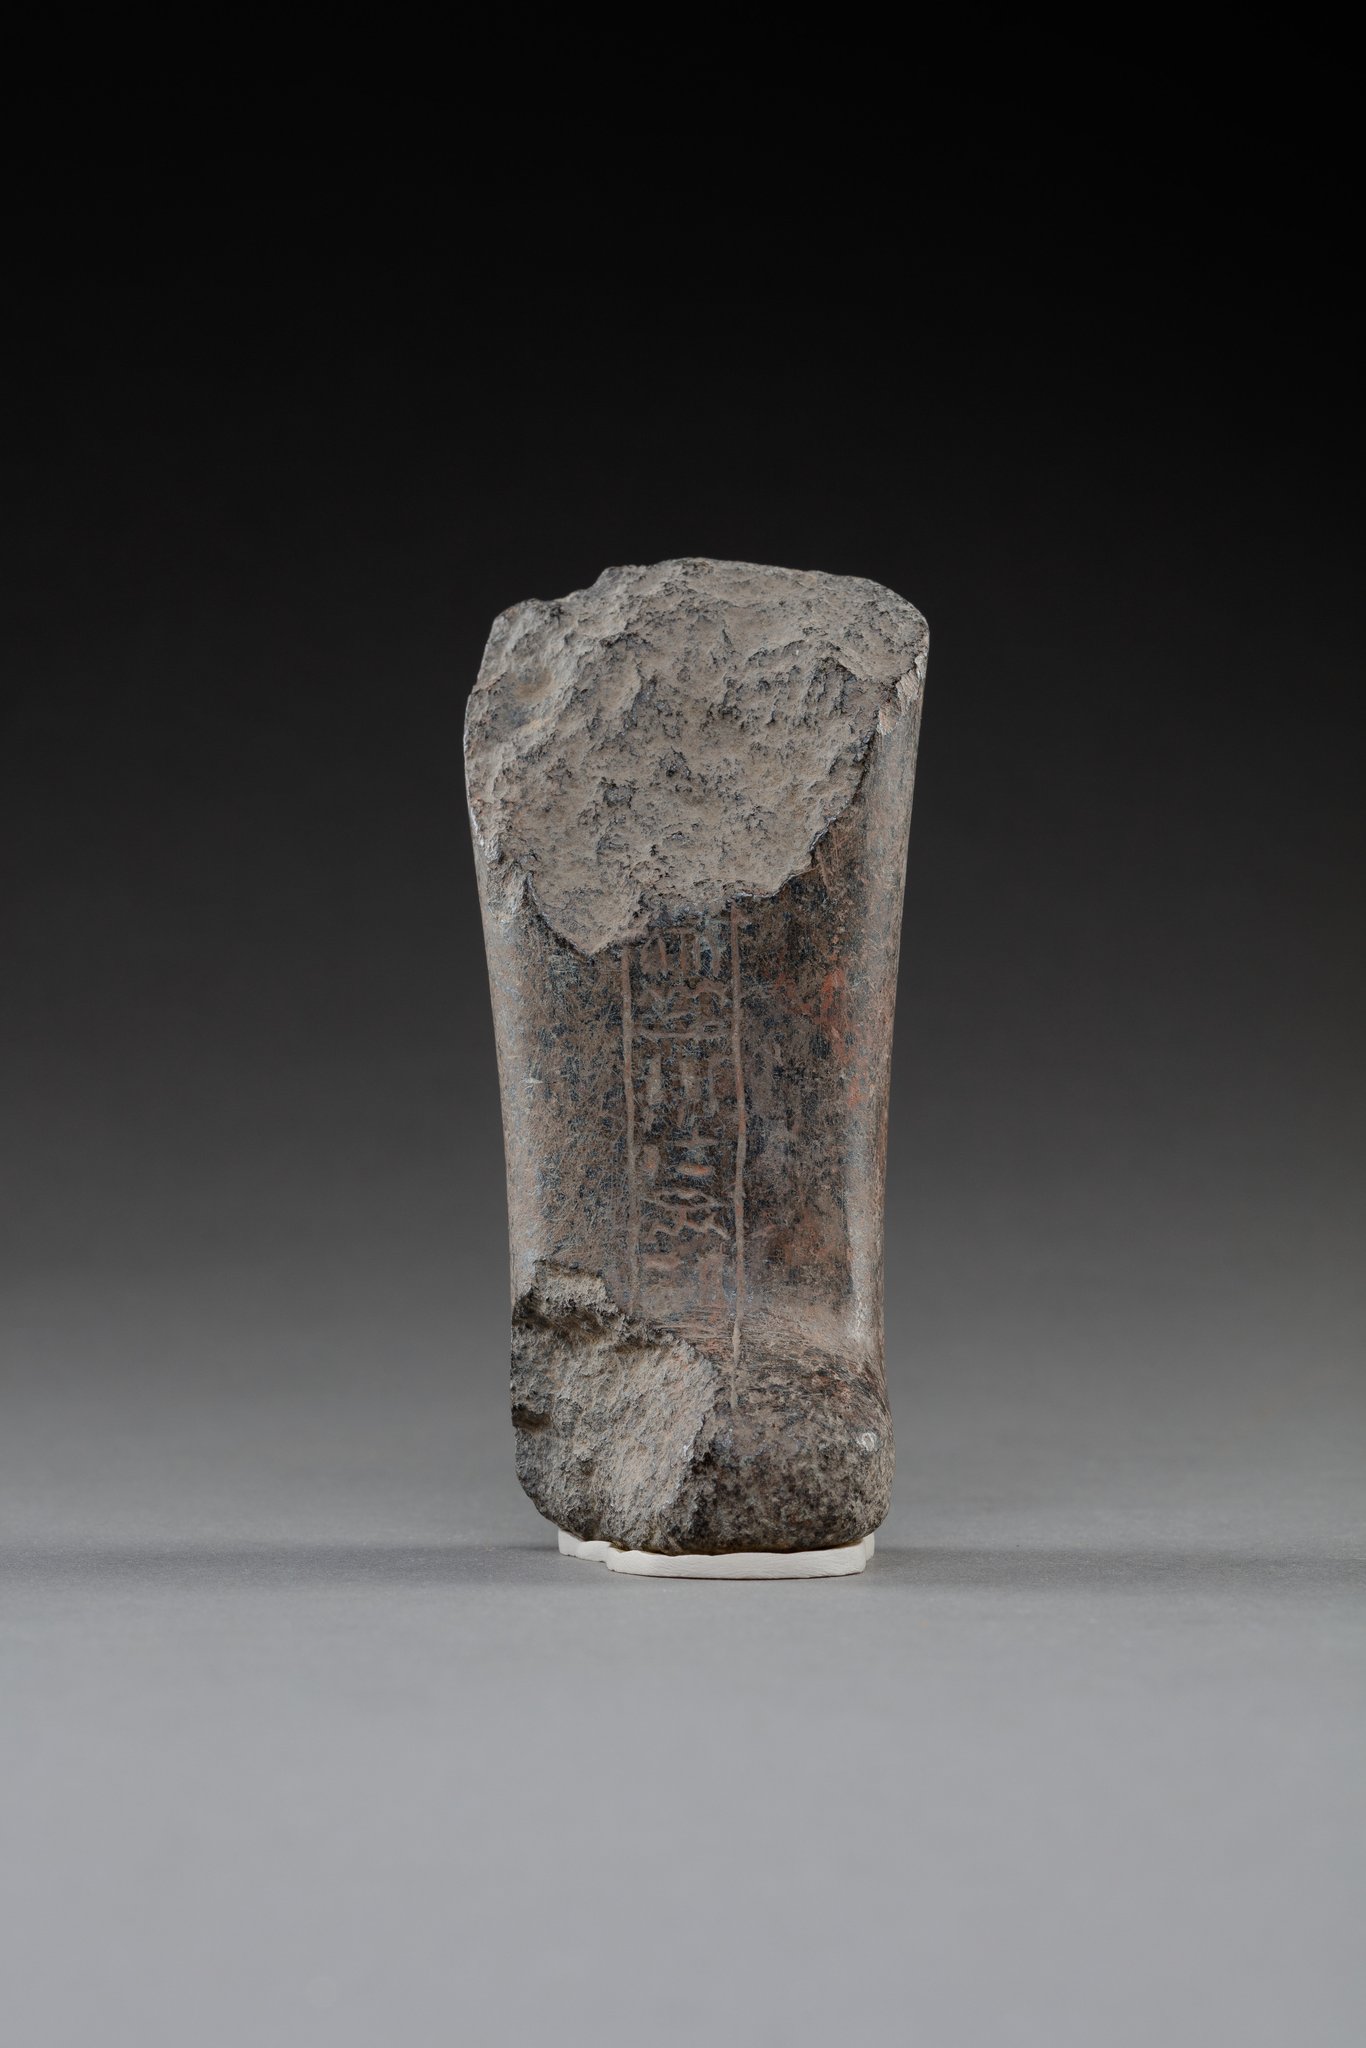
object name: shabti leg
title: Shabti legs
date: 1850-1640 BCE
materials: paint, stone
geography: egypt